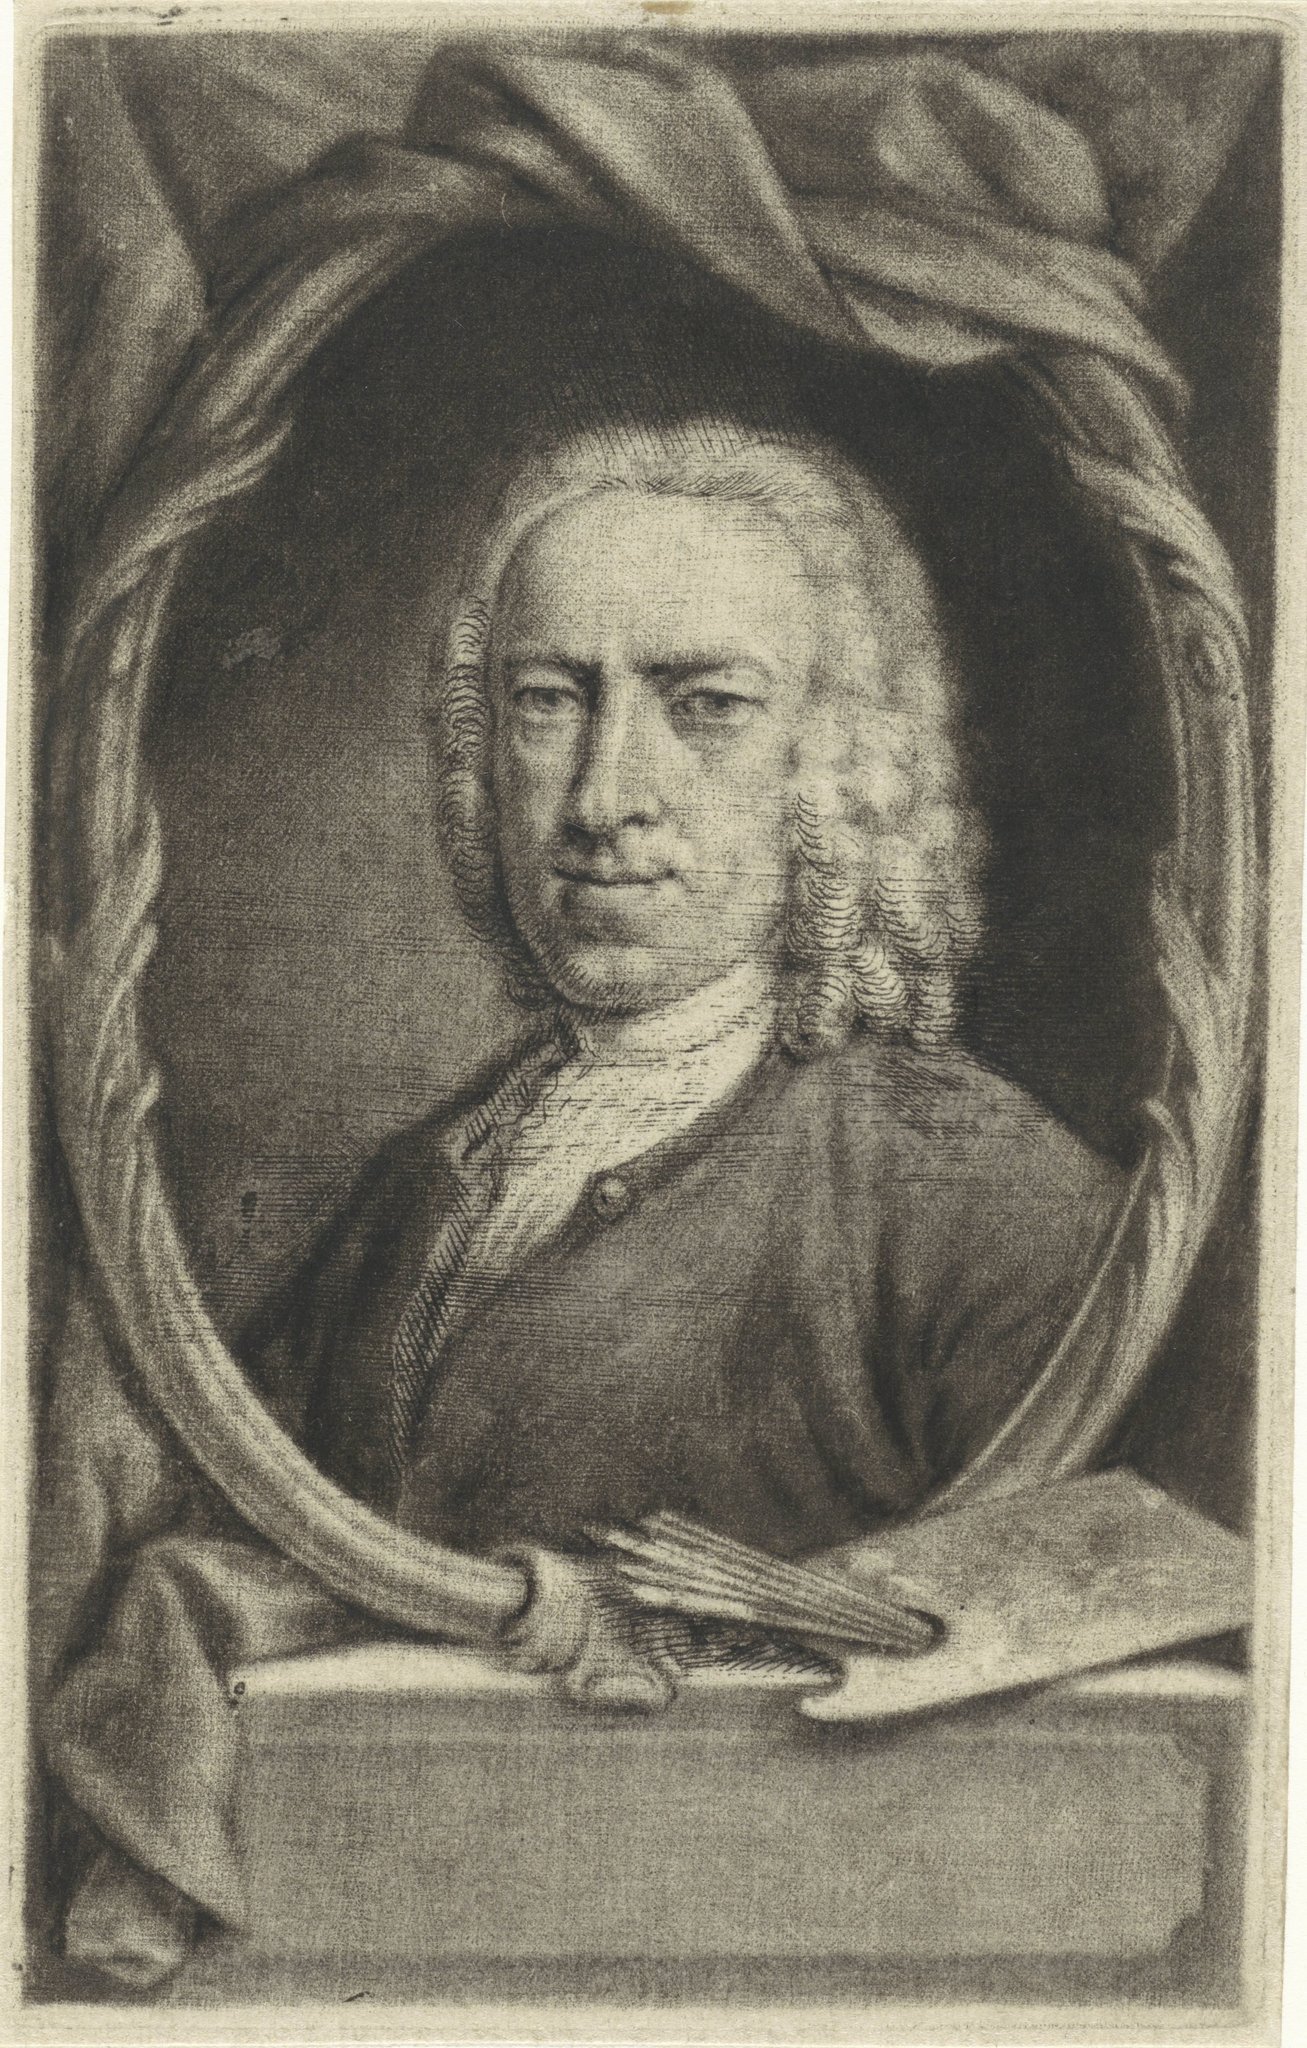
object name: print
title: Zelfportret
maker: aert schouman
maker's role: draughtsman, painter, print maker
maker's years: 1710-1792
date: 1740-1792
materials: paper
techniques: etching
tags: dordrecht, the hague, draughtsman, aert schouman, portrait, self-portrait of painter, tools, implements of painter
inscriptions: collector's mark: Lugt 2228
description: De schilder en prentmaker Aert Schouman. Buiten de omlijsting liggen penselen en een palet.